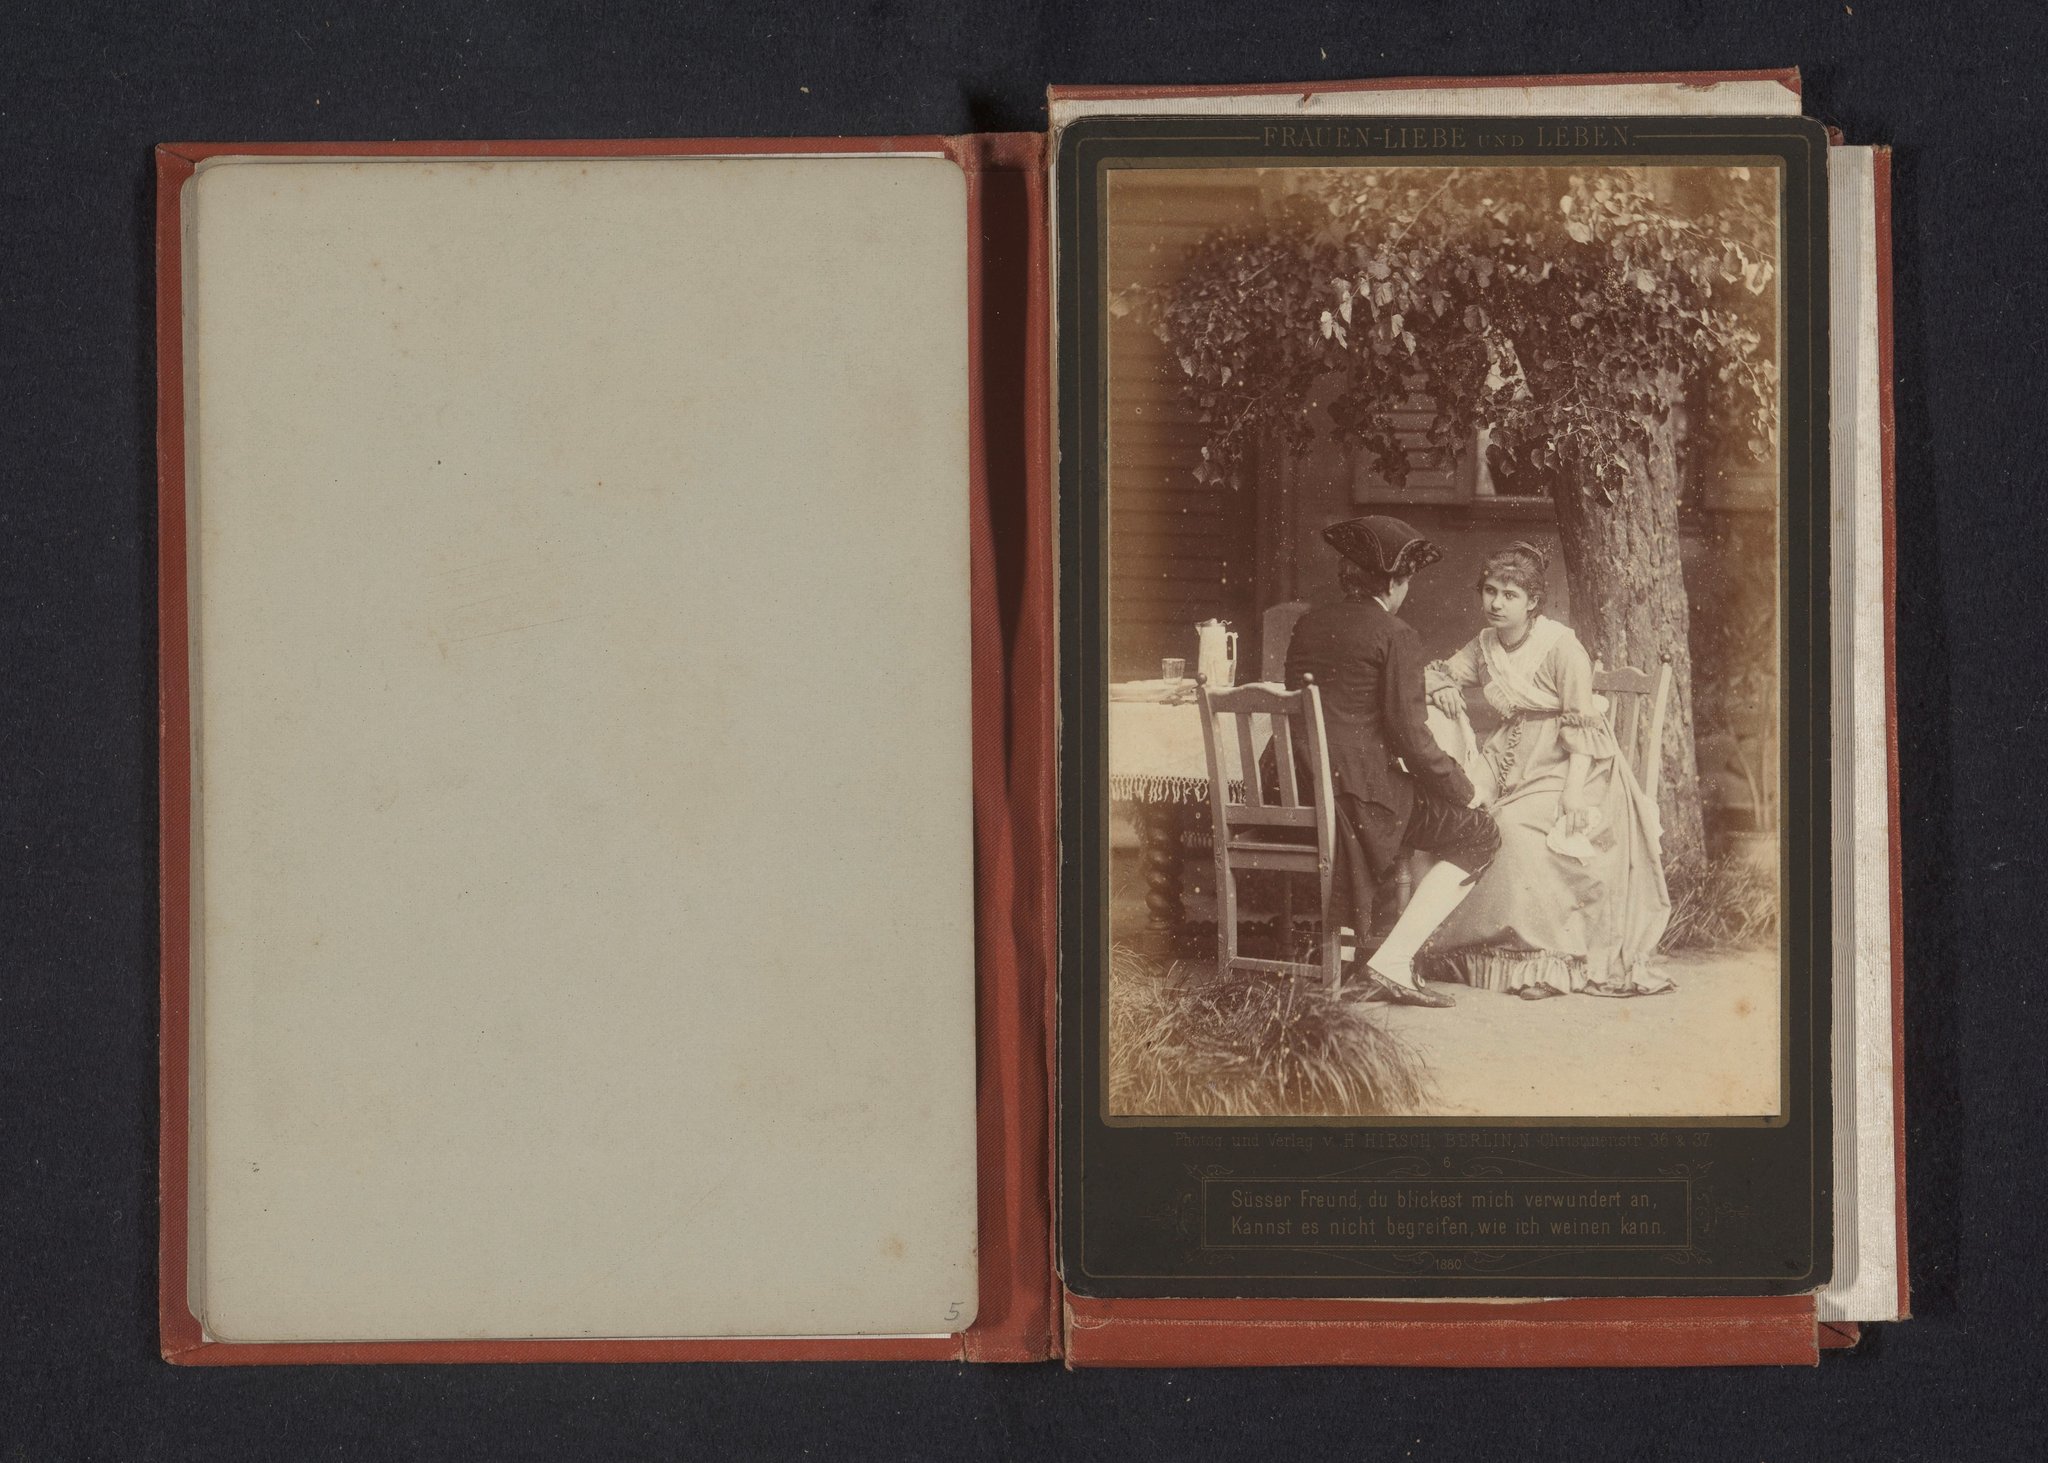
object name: page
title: Frauen-Liebe und Leben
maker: hugo hirsch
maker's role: publisher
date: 1880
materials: photographic support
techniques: albumen print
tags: adult woman, garden, adult man, historical costume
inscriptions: number: ‘6.’, name: ‘Photog. und Verlag v. H. Hirsch, Berlin, N Christinenstr. 36 & 37’